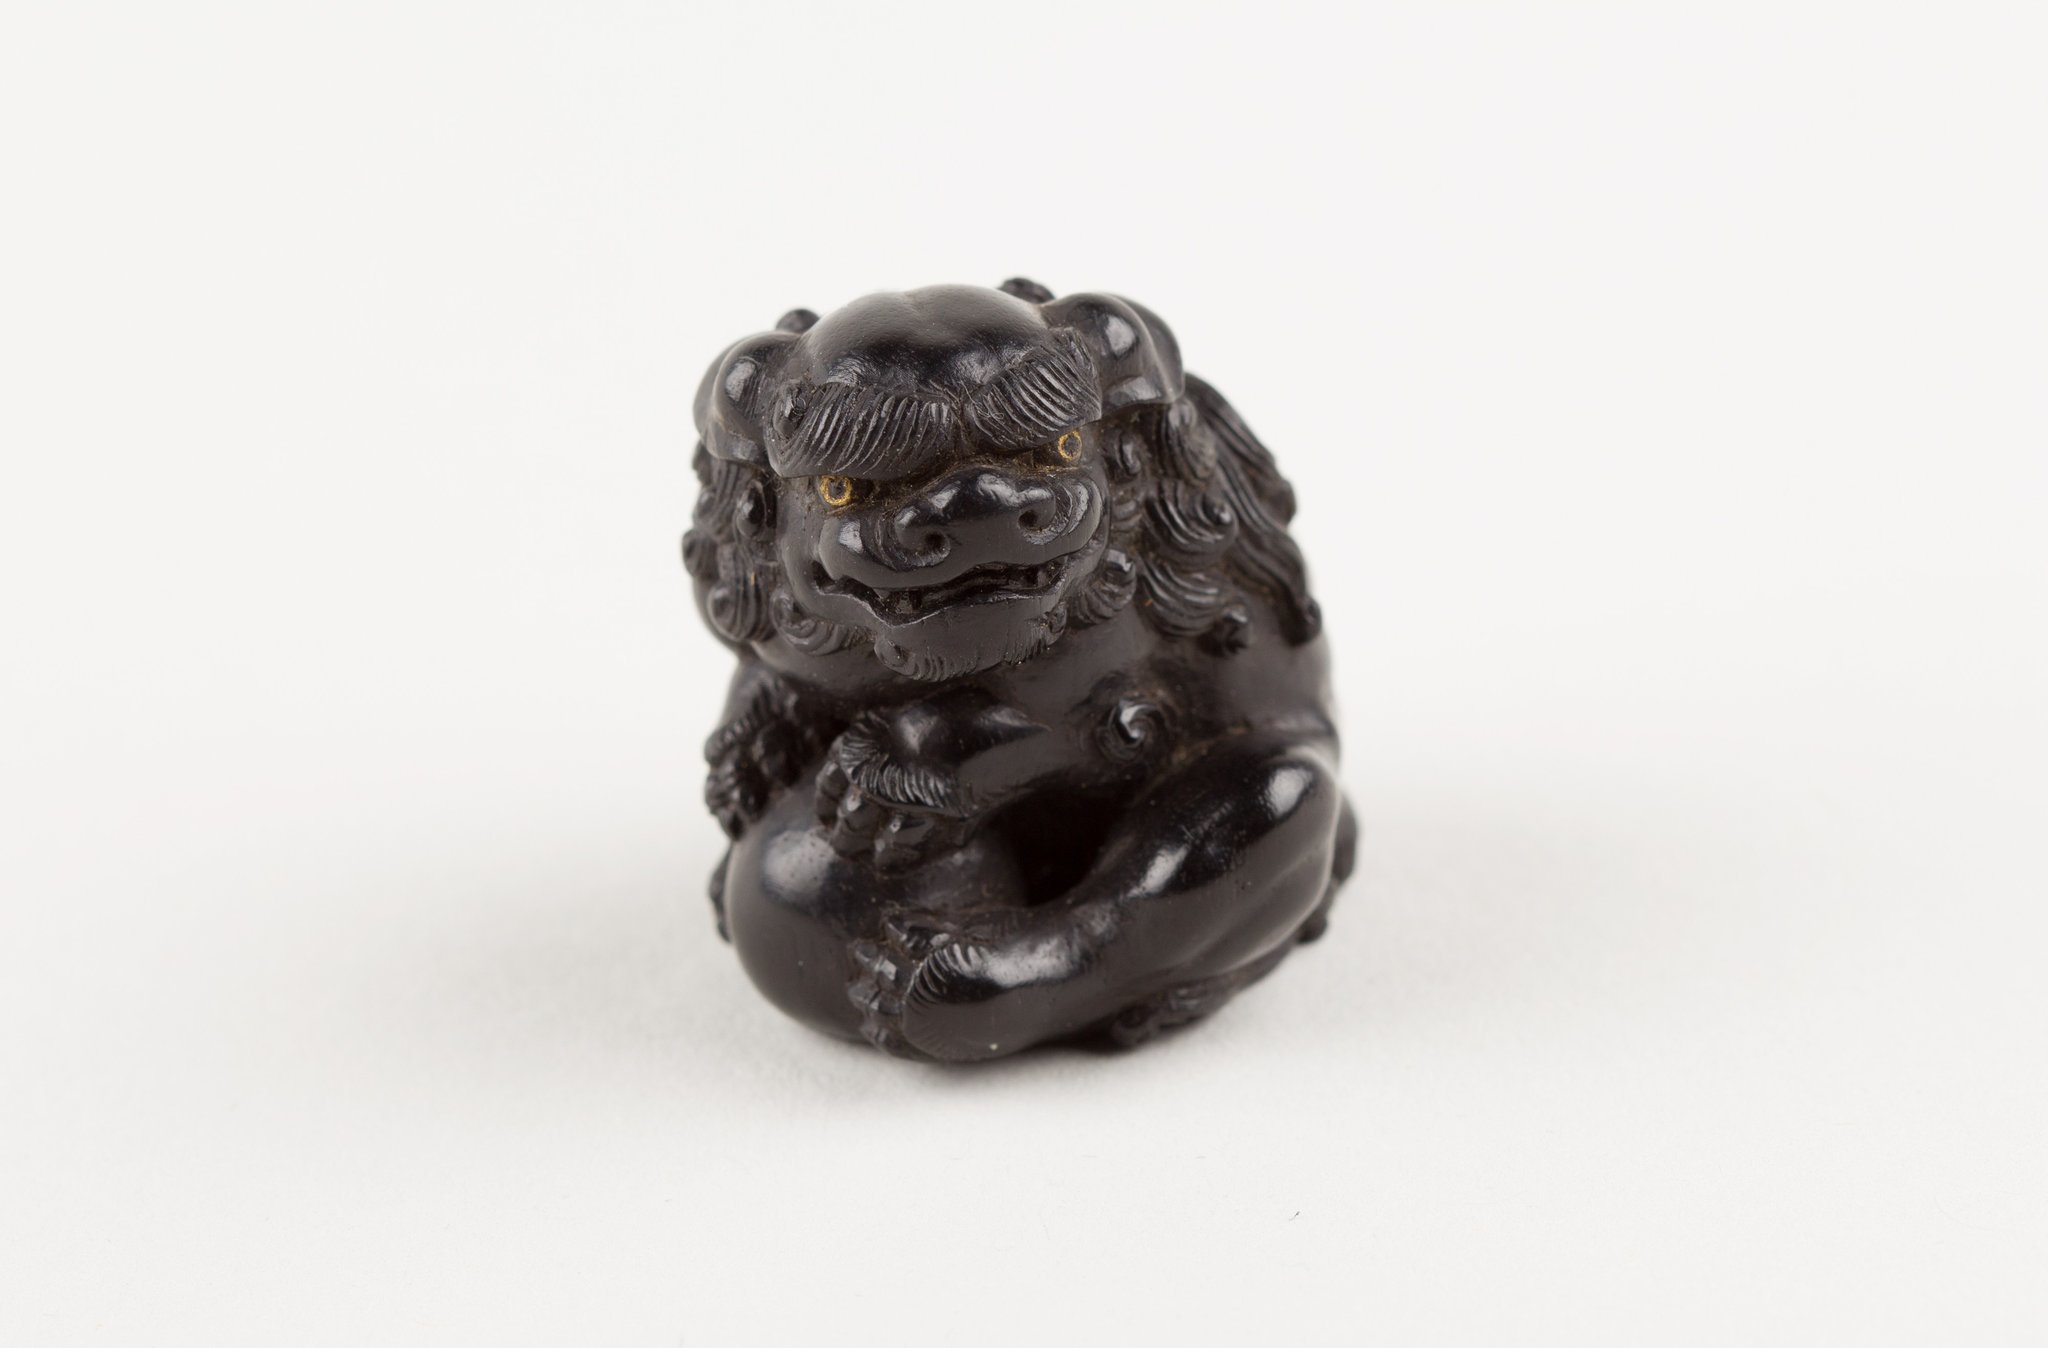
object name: netsuke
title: Netsuke of Seated Shishi Clutching a Ball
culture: japanese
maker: ryōzan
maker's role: artist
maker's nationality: japanese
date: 1867-1900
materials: wood, gold, horn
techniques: inlay